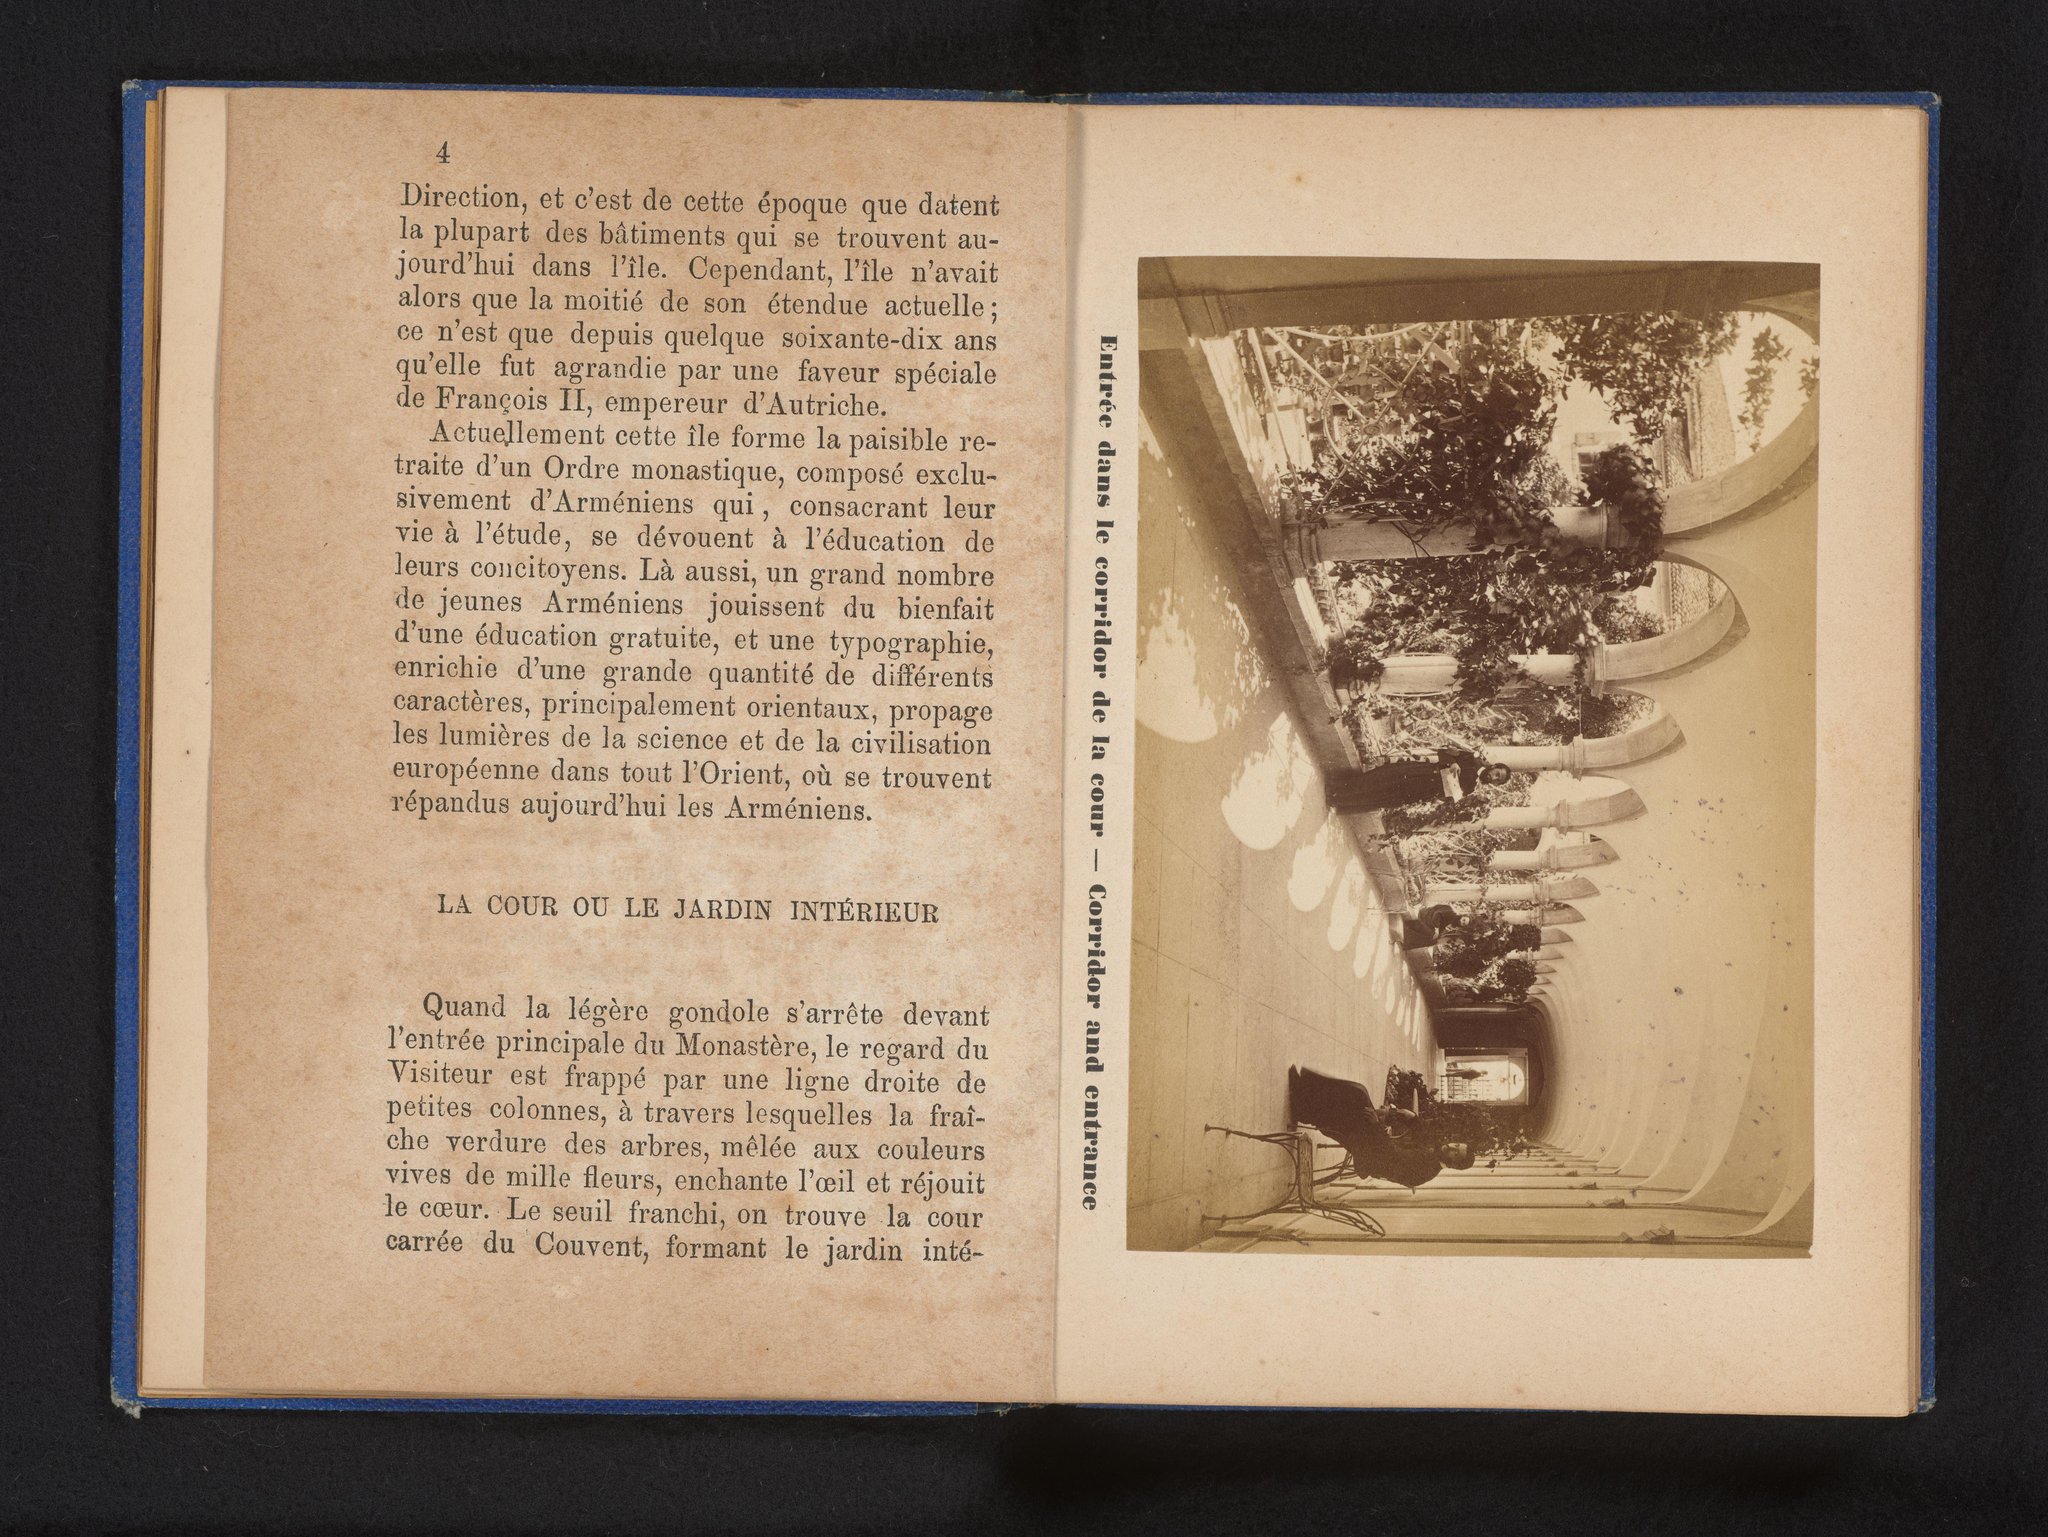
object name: page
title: Kloostergang van het Armeense klooster te San Lazzaro degli Armeni, Venetië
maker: Anonymous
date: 1874-1879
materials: paper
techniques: albumen print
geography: venice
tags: cloisters ~ monastery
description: Foto op ongenummerde pagina tegenover pagina 4.